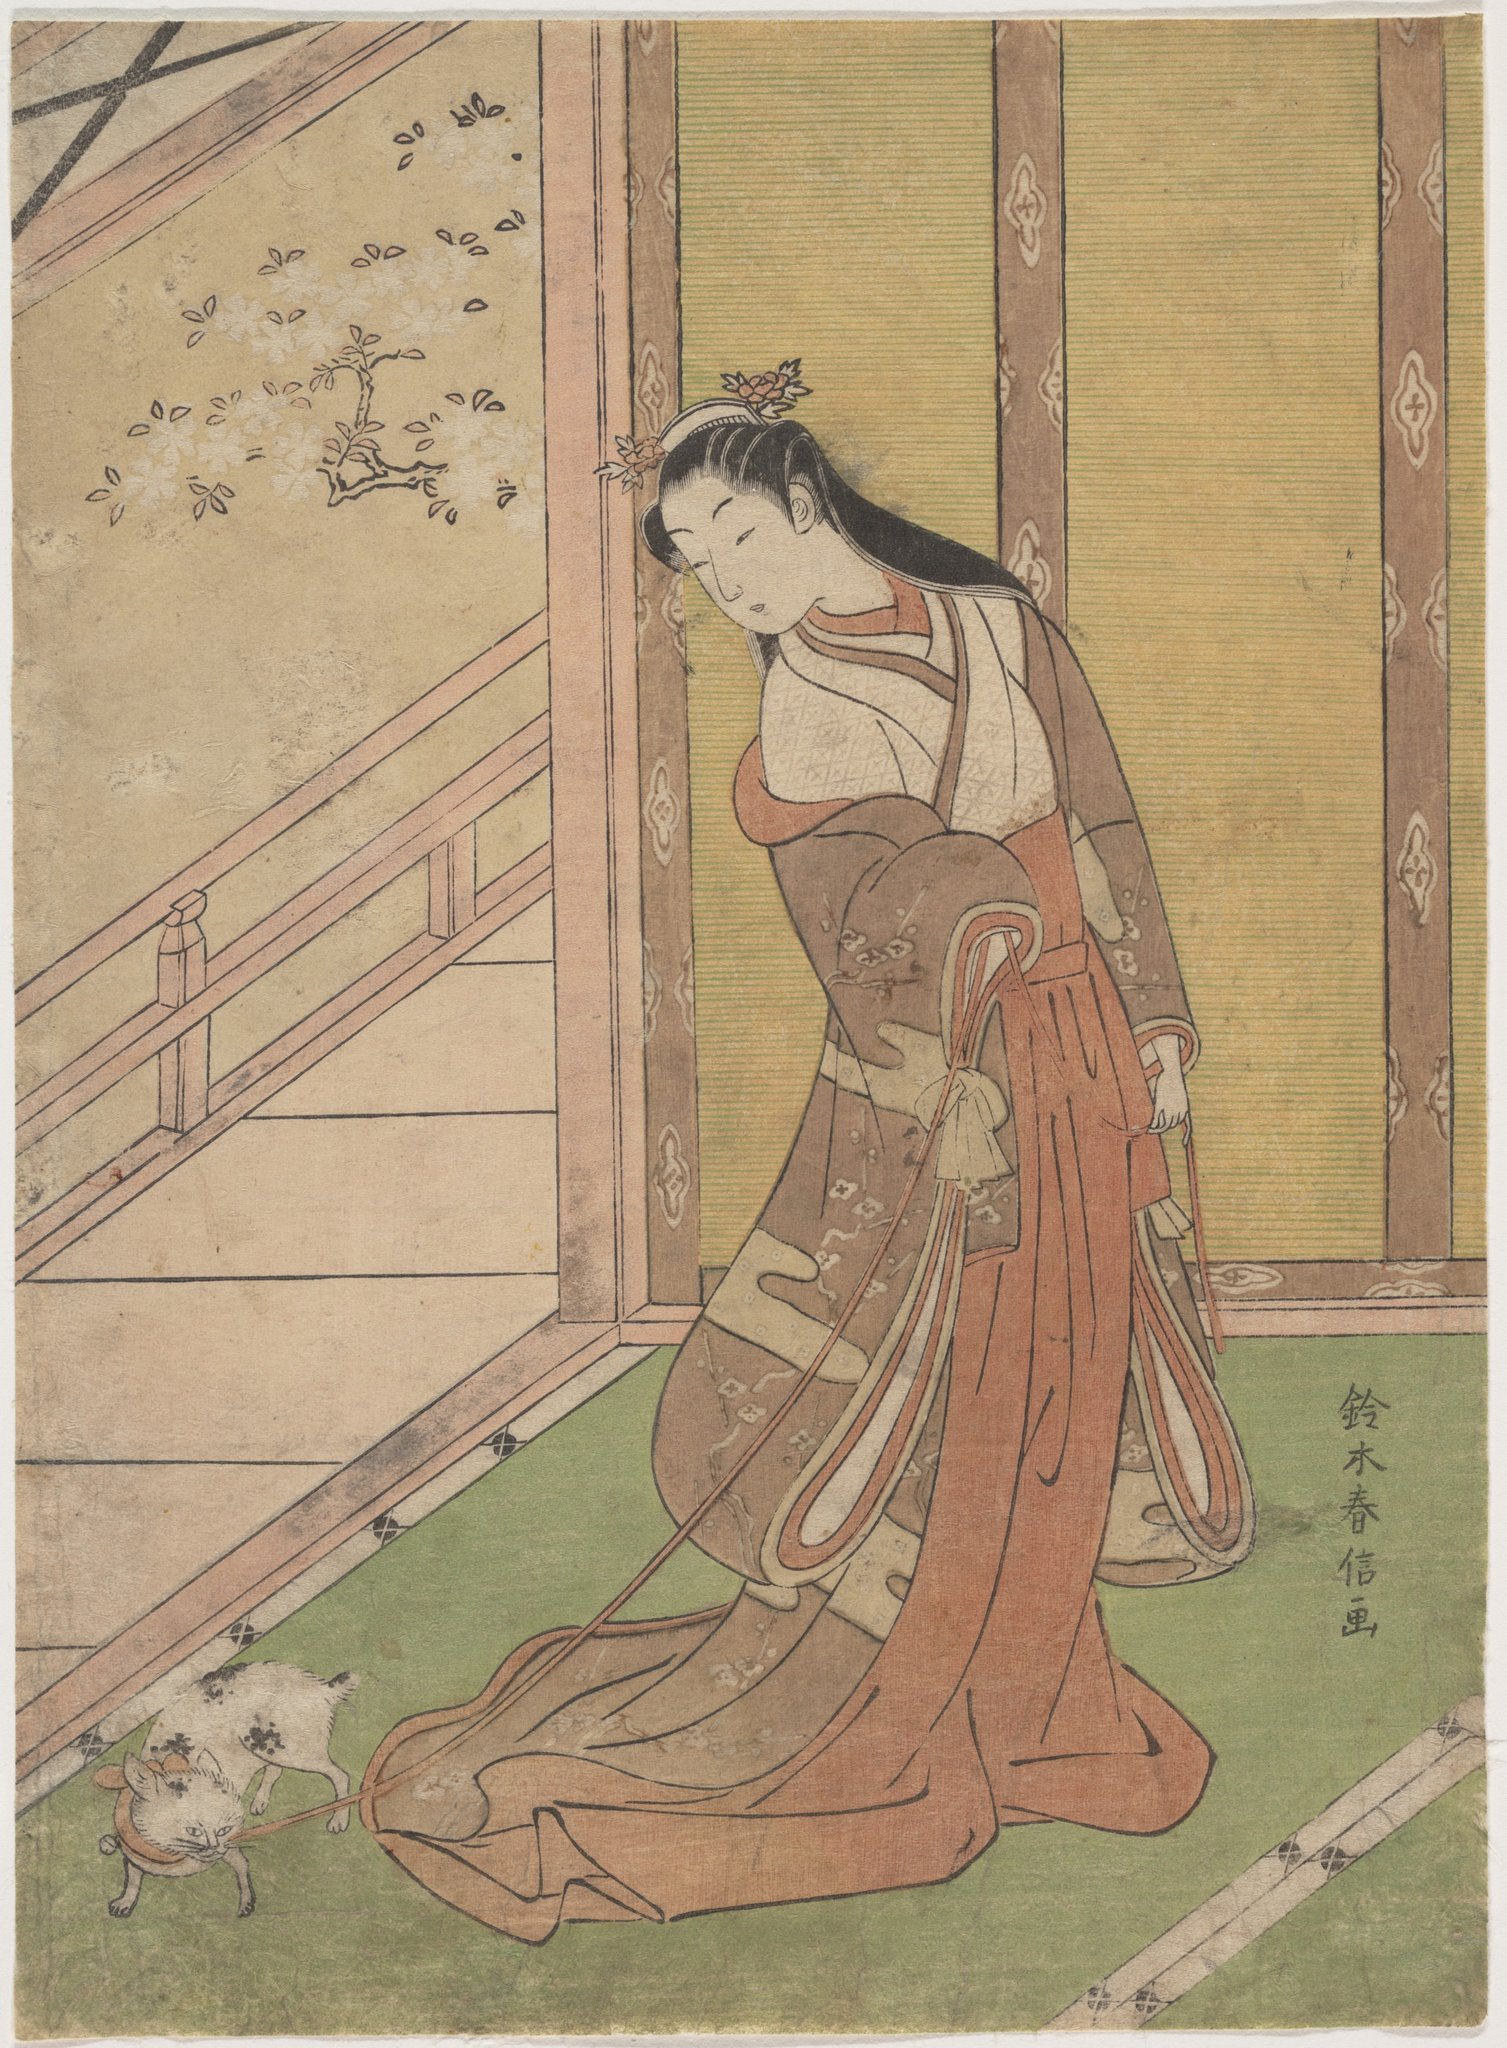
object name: print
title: Onna San no Miya (the Third Princess)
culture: japanese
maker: suzuki harunobu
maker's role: artist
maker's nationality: japanese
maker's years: 1725-1770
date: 1768-1770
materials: ink, paper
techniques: woodblock print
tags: women,cats